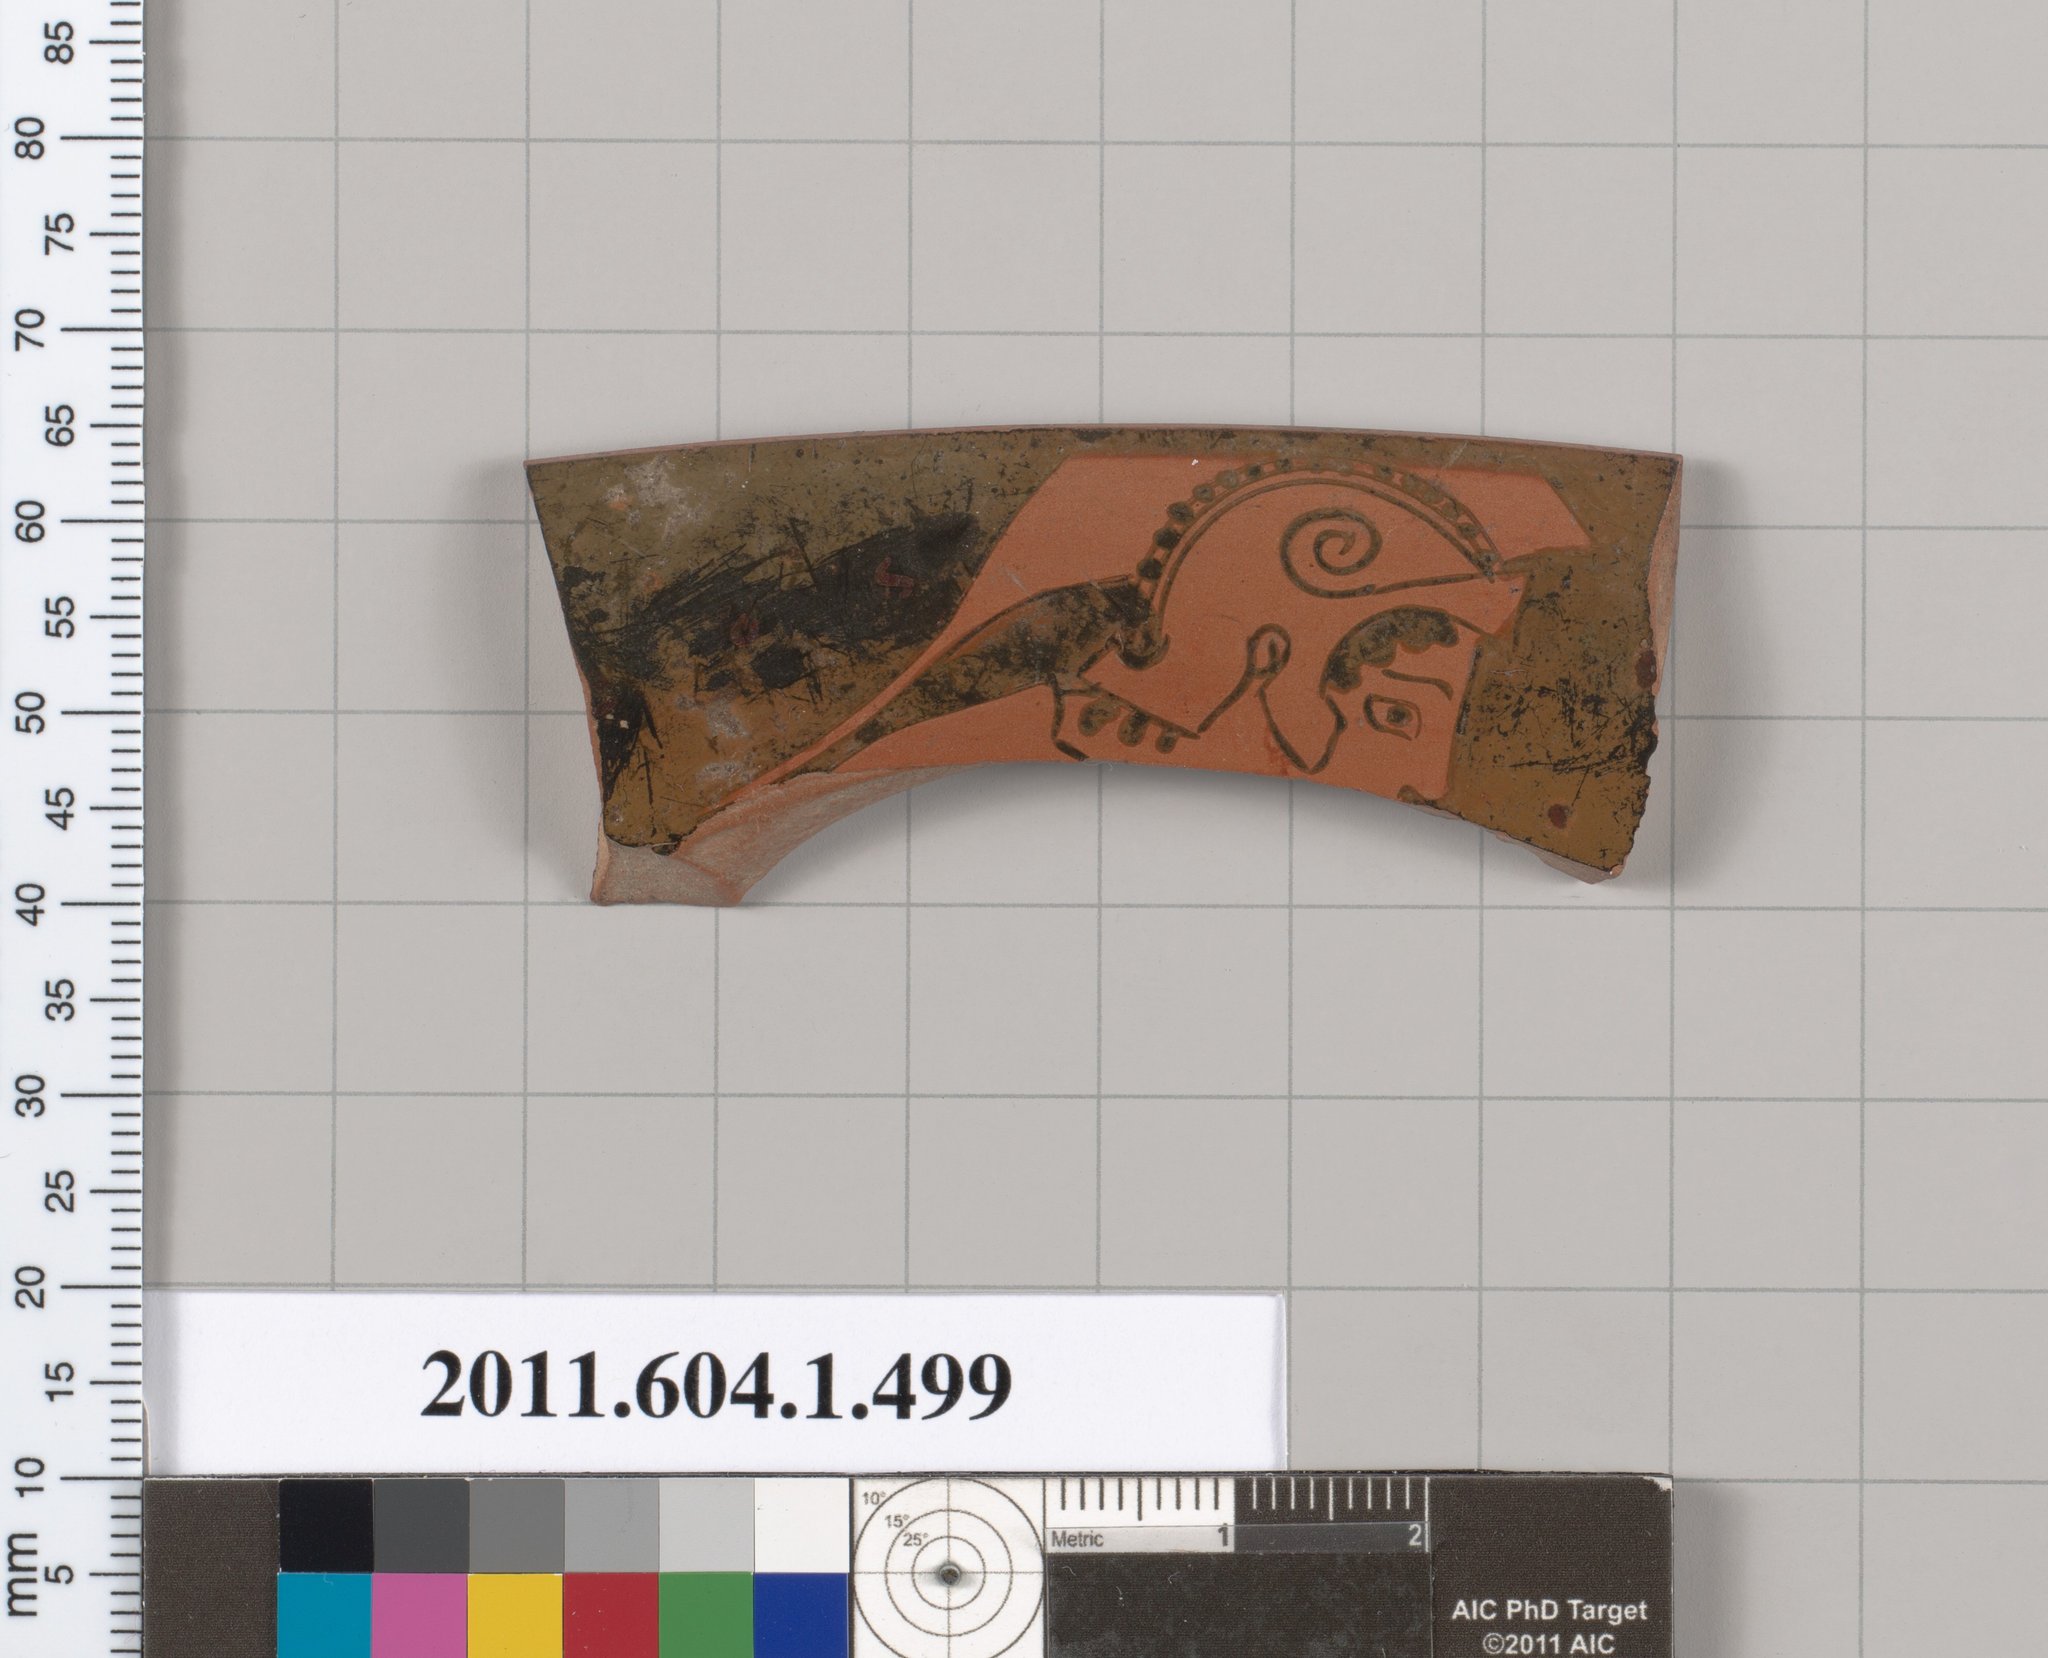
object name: kylix fragment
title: Terracotta rim fragment of a kylix (drinking cup)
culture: greek, attic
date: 534-501 BCE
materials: terracotta